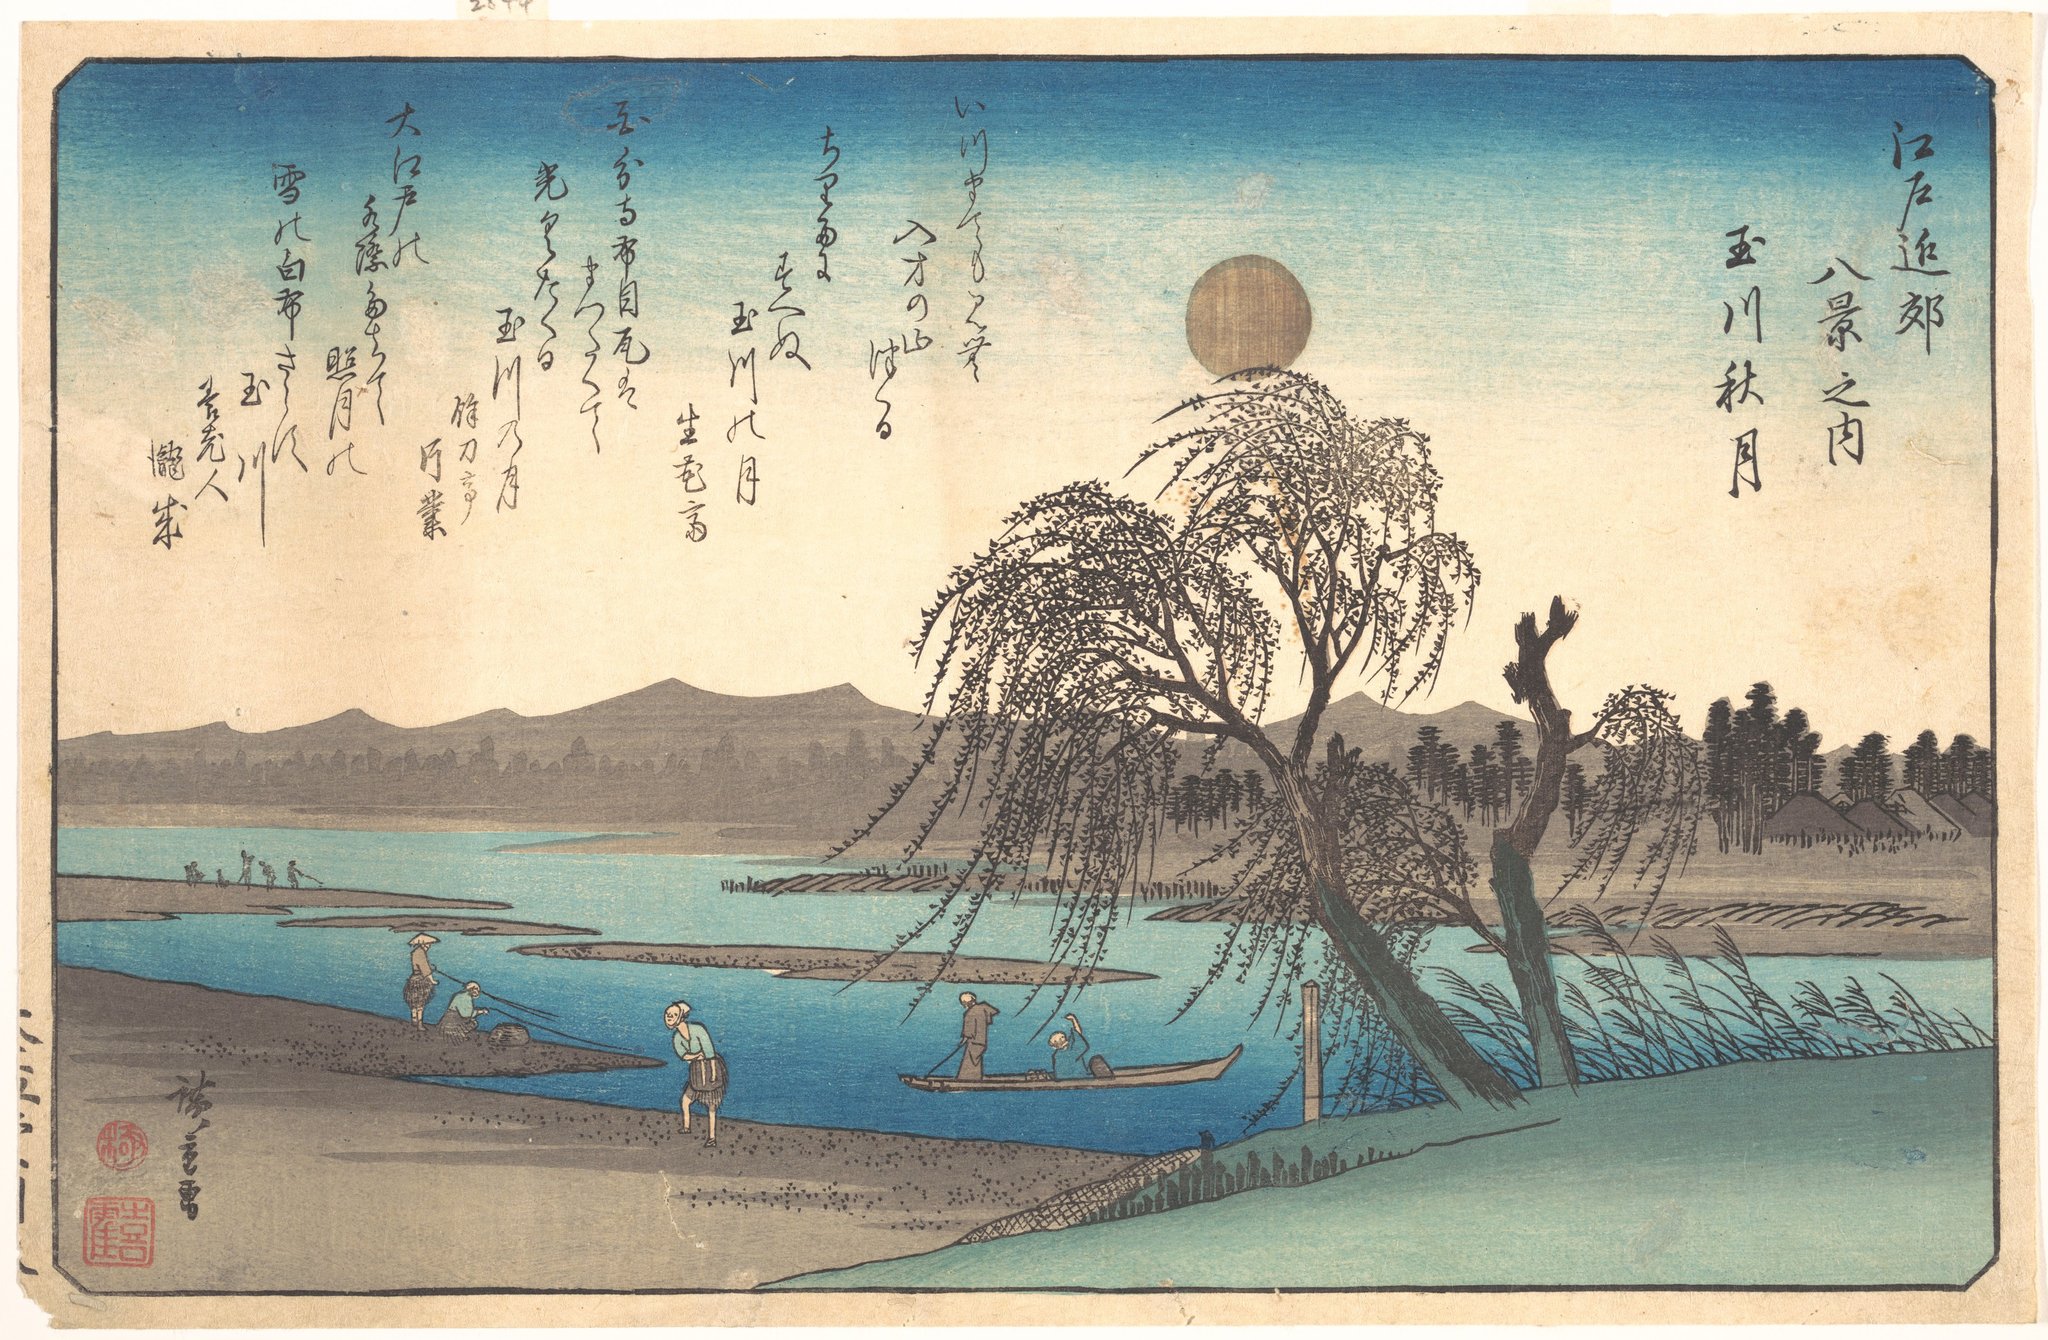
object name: print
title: Autumn Moon on the Tama River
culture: japanese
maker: utagawa hiroshige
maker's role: artist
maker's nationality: japanese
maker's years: 1797-1858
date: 1838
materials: ink, paper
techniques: woodblock print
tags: human figures,rivers,moon,trees,boats